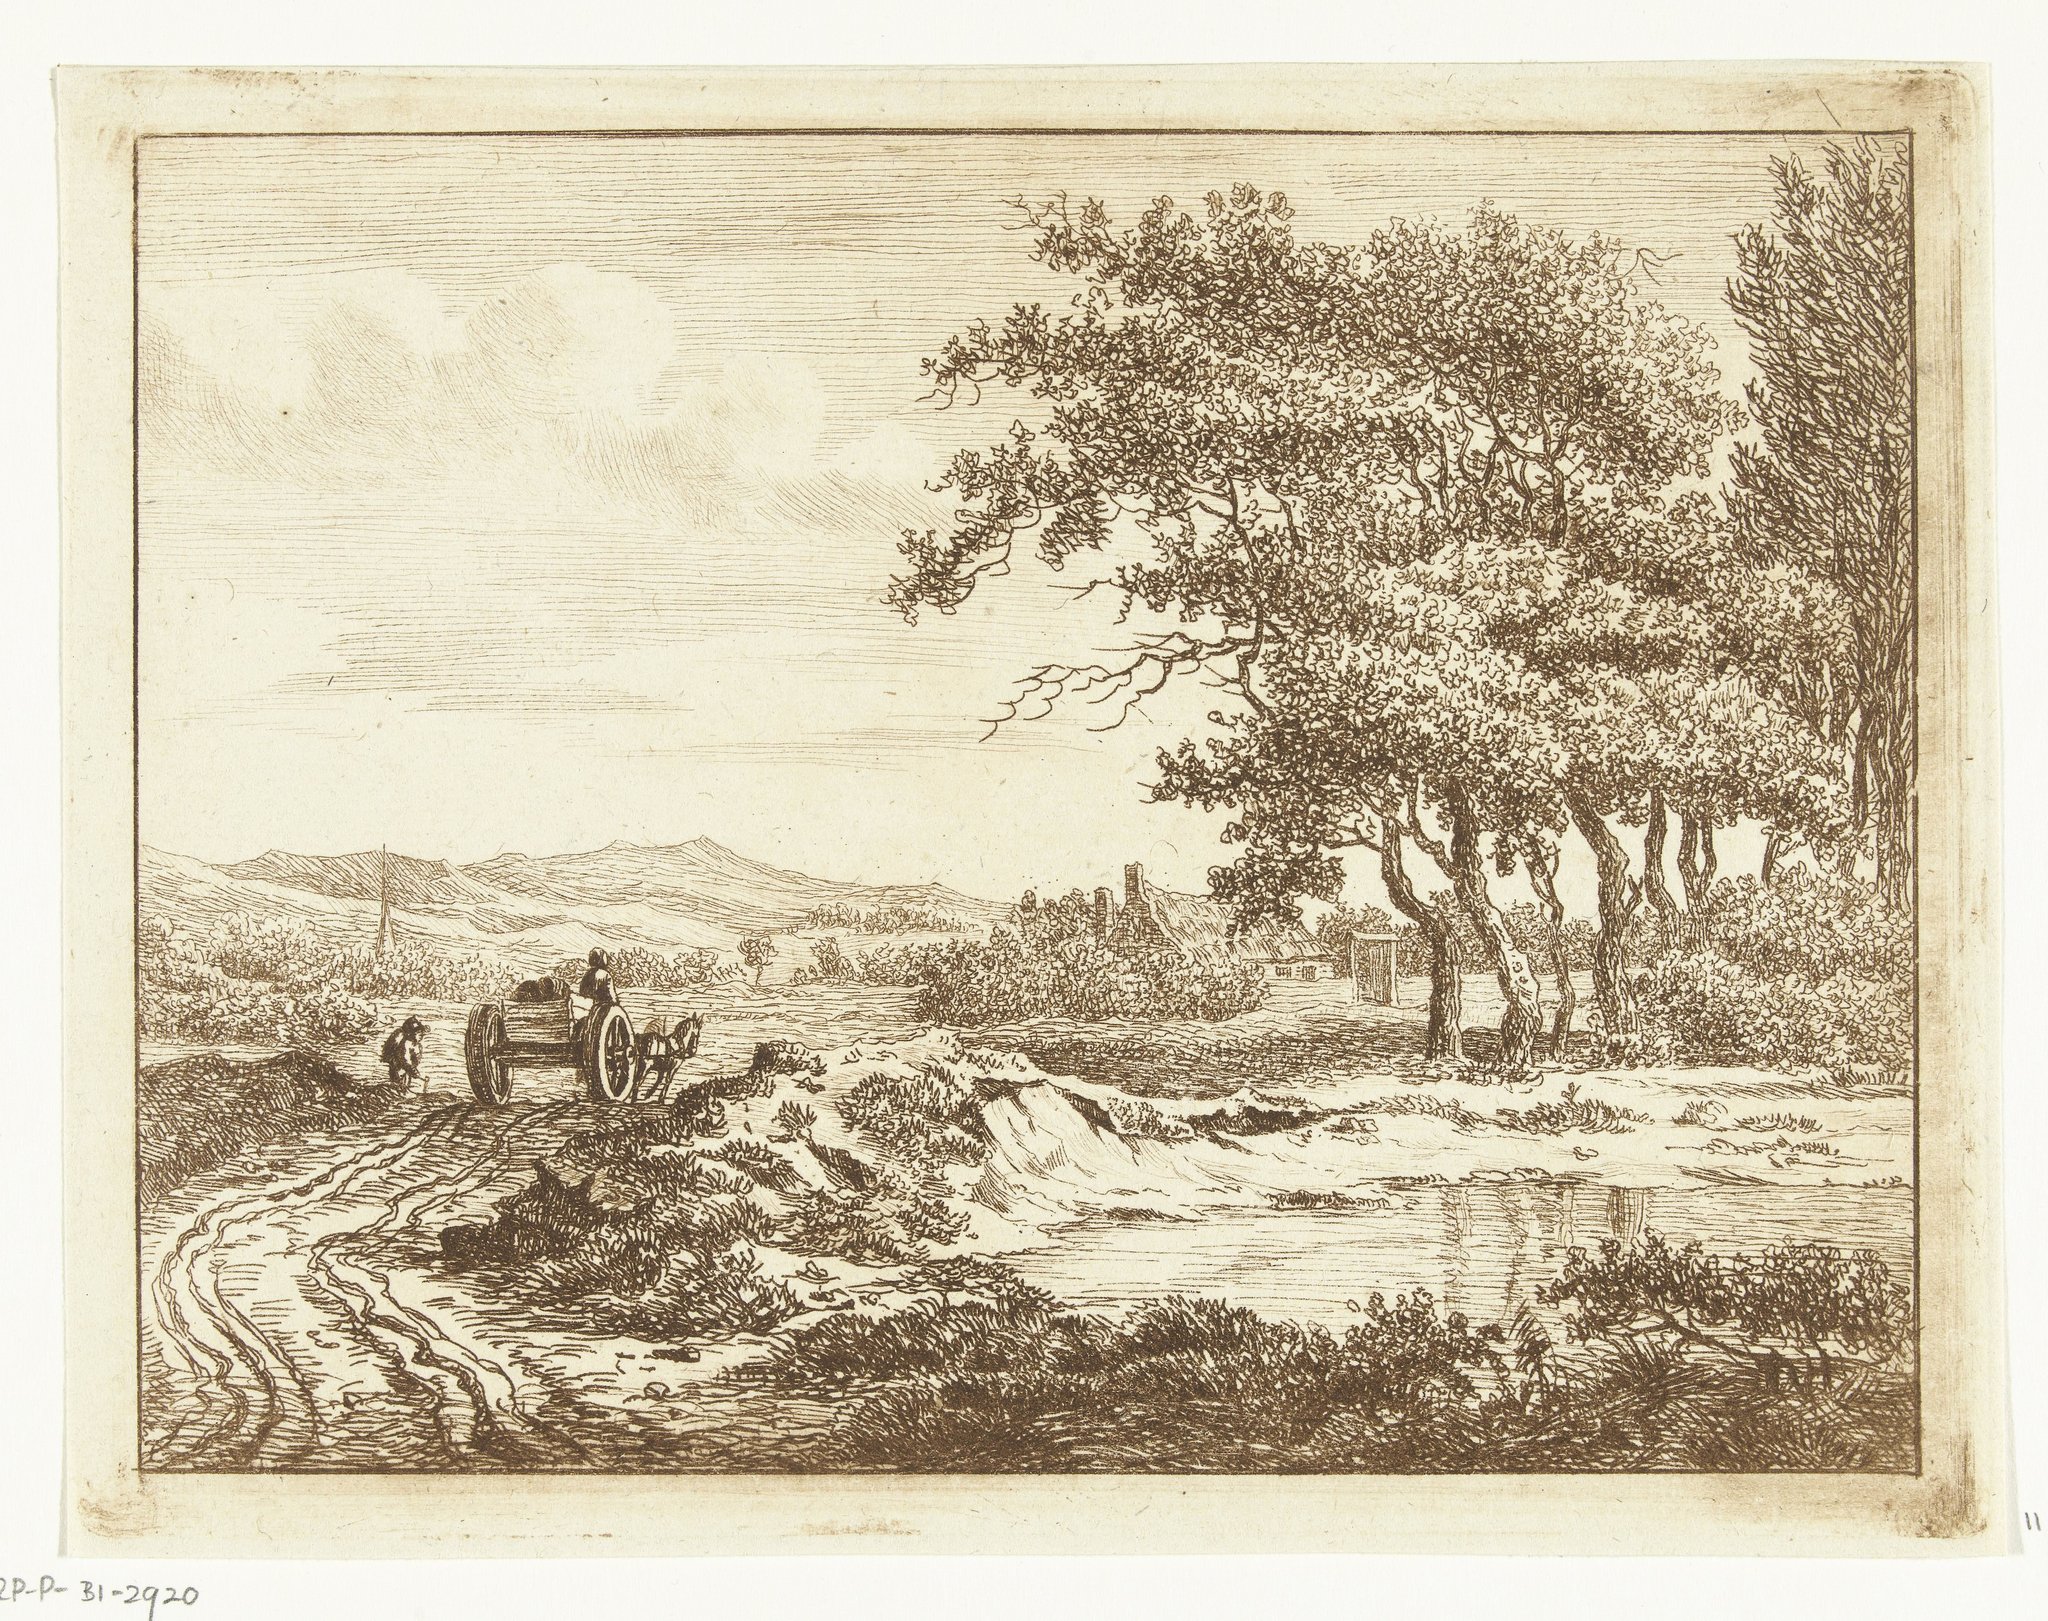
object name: print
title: Kar op een landweg bij de duinen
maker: anthonie van den bos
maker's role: draughtsman, print maker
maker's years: 1763-1838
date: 1778-1838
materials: paper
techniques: etching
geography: netherlands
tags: ruin of a dwelling, house, castle, etc.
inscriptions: collector's mark: Lugt 2228